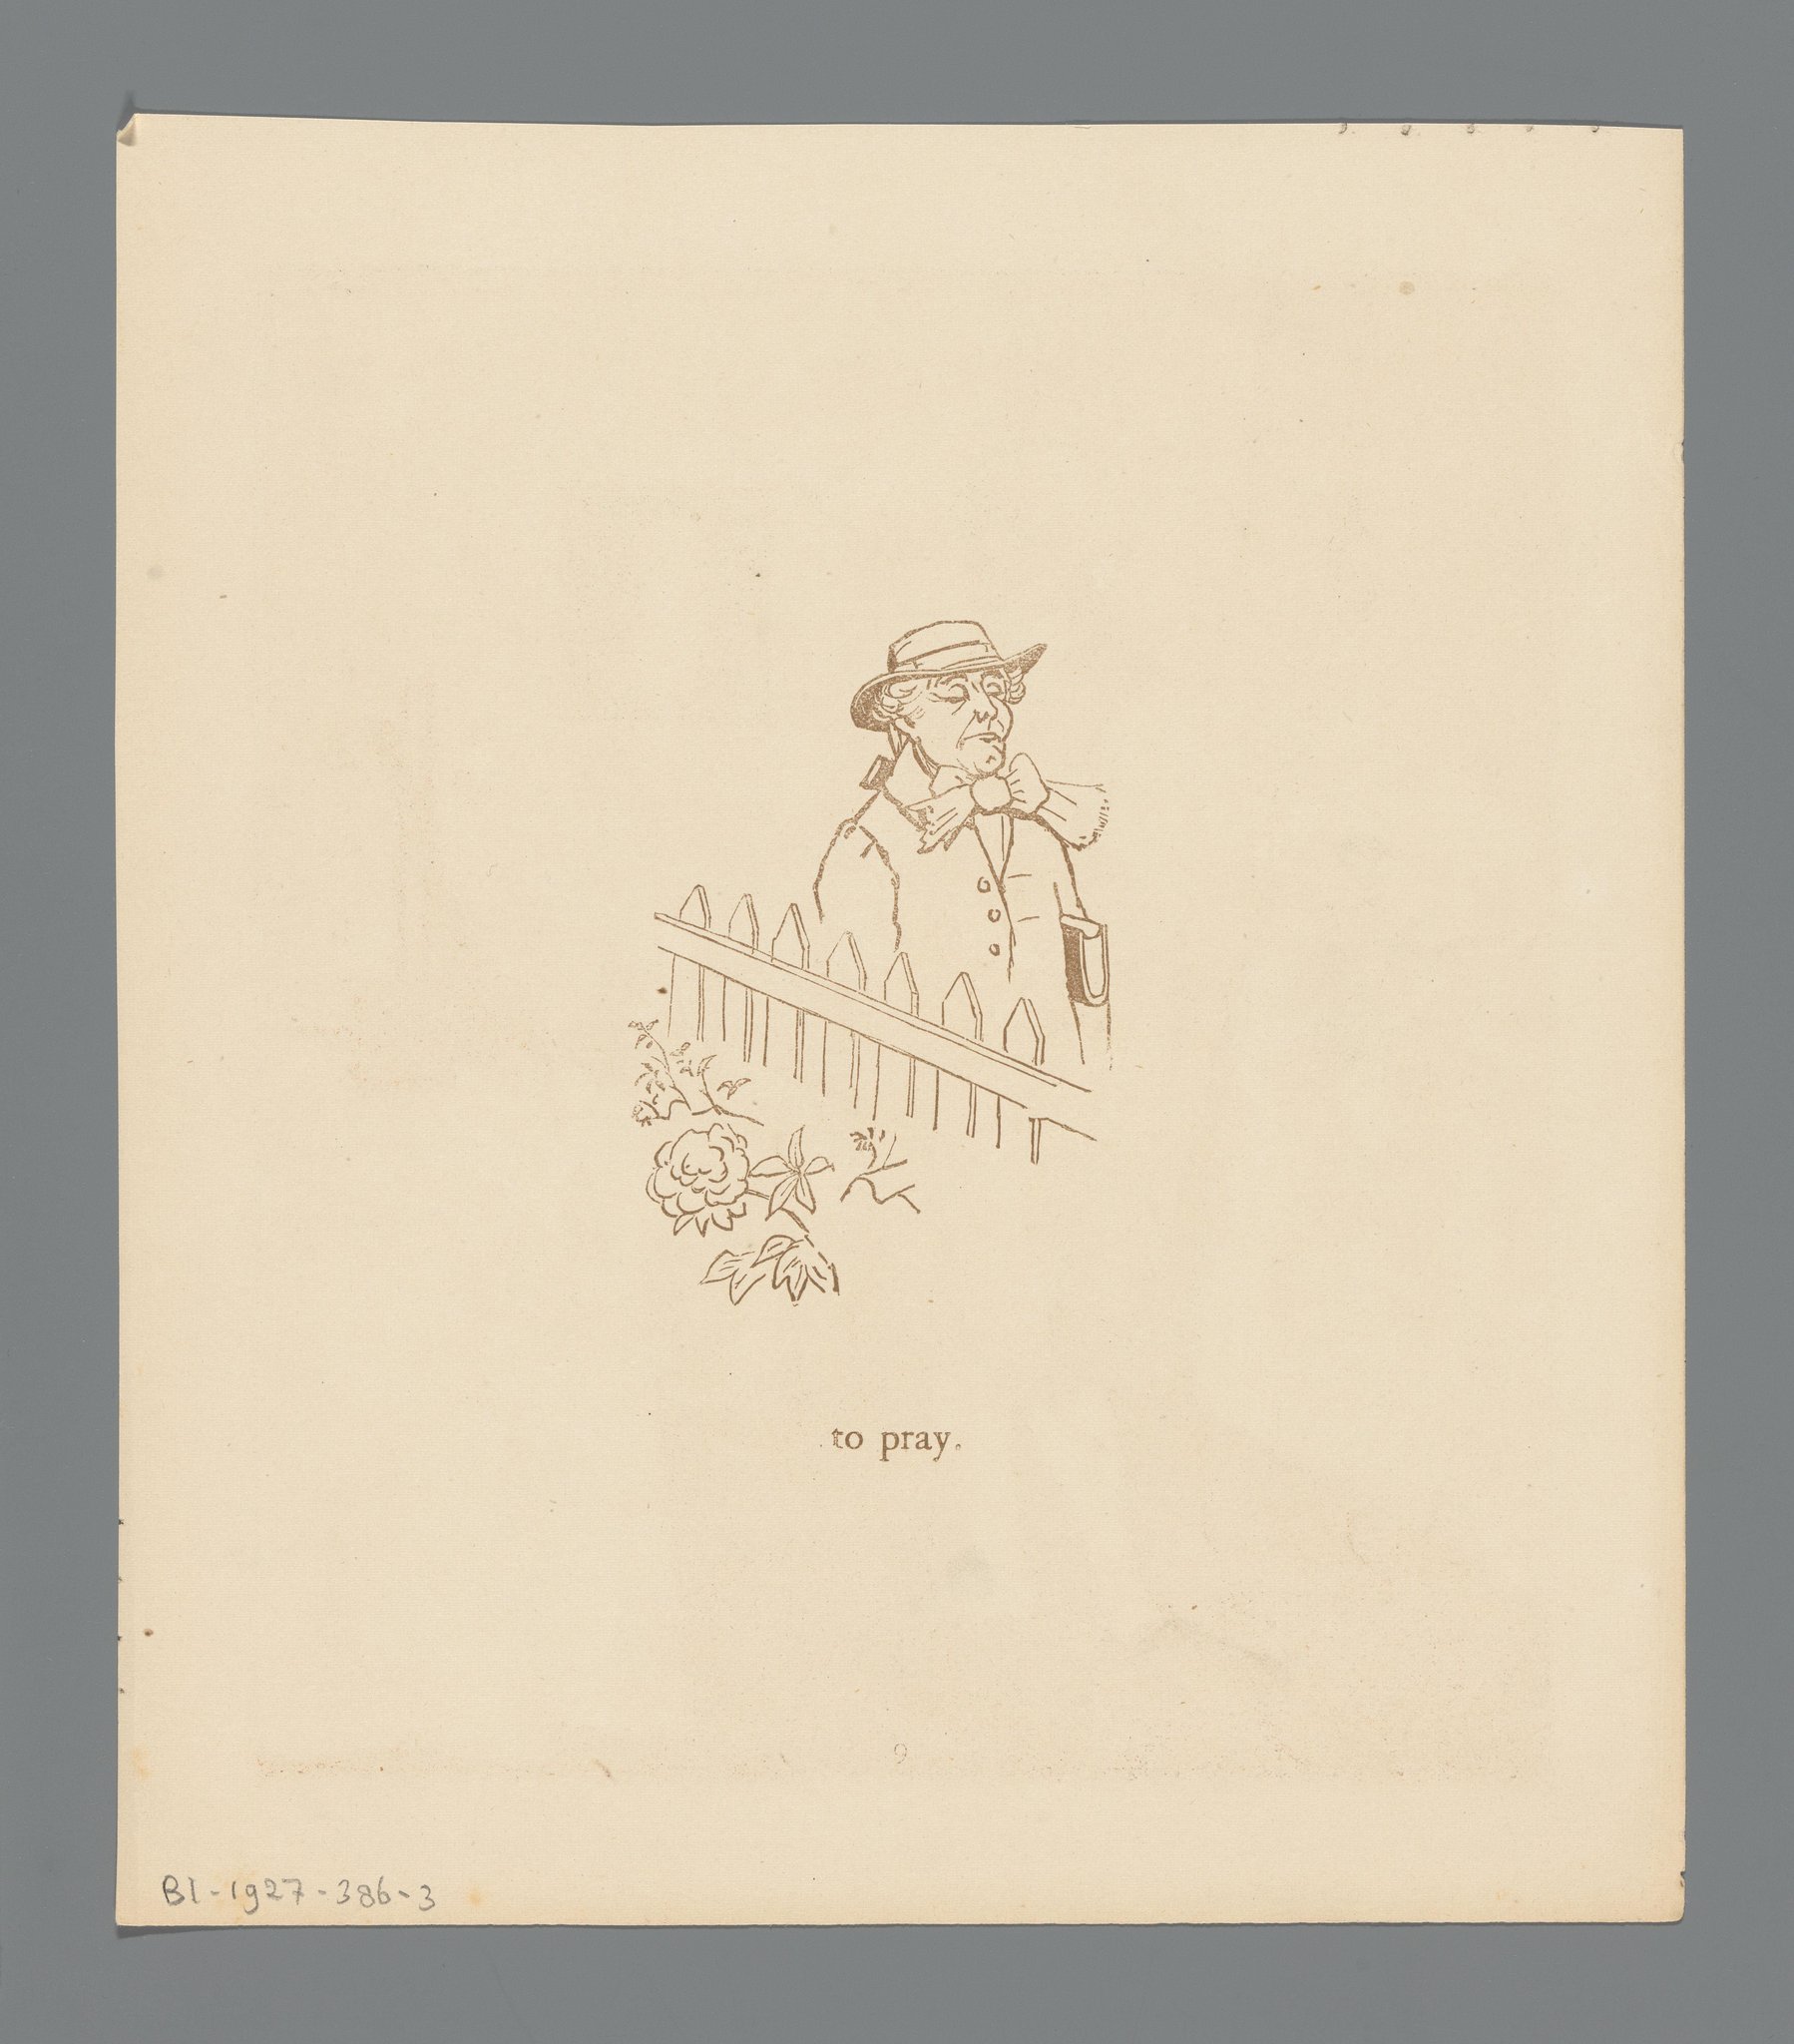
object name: book illustration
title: Man met hoed bij een hek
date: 1879-1927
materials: paper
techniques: letterpress printing, engraving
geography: london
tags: head-gear, fence, wall, paling, adult man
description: Prent uit: Goldsmith, Oliver. Elegy on a mad dog. Londen: George Routledge & Sons, 1879. Of uit een later gepubliceerde uitgave waarin vier verhalen (waaronder 'Elegy on a mad dog') zijn gebundeld.